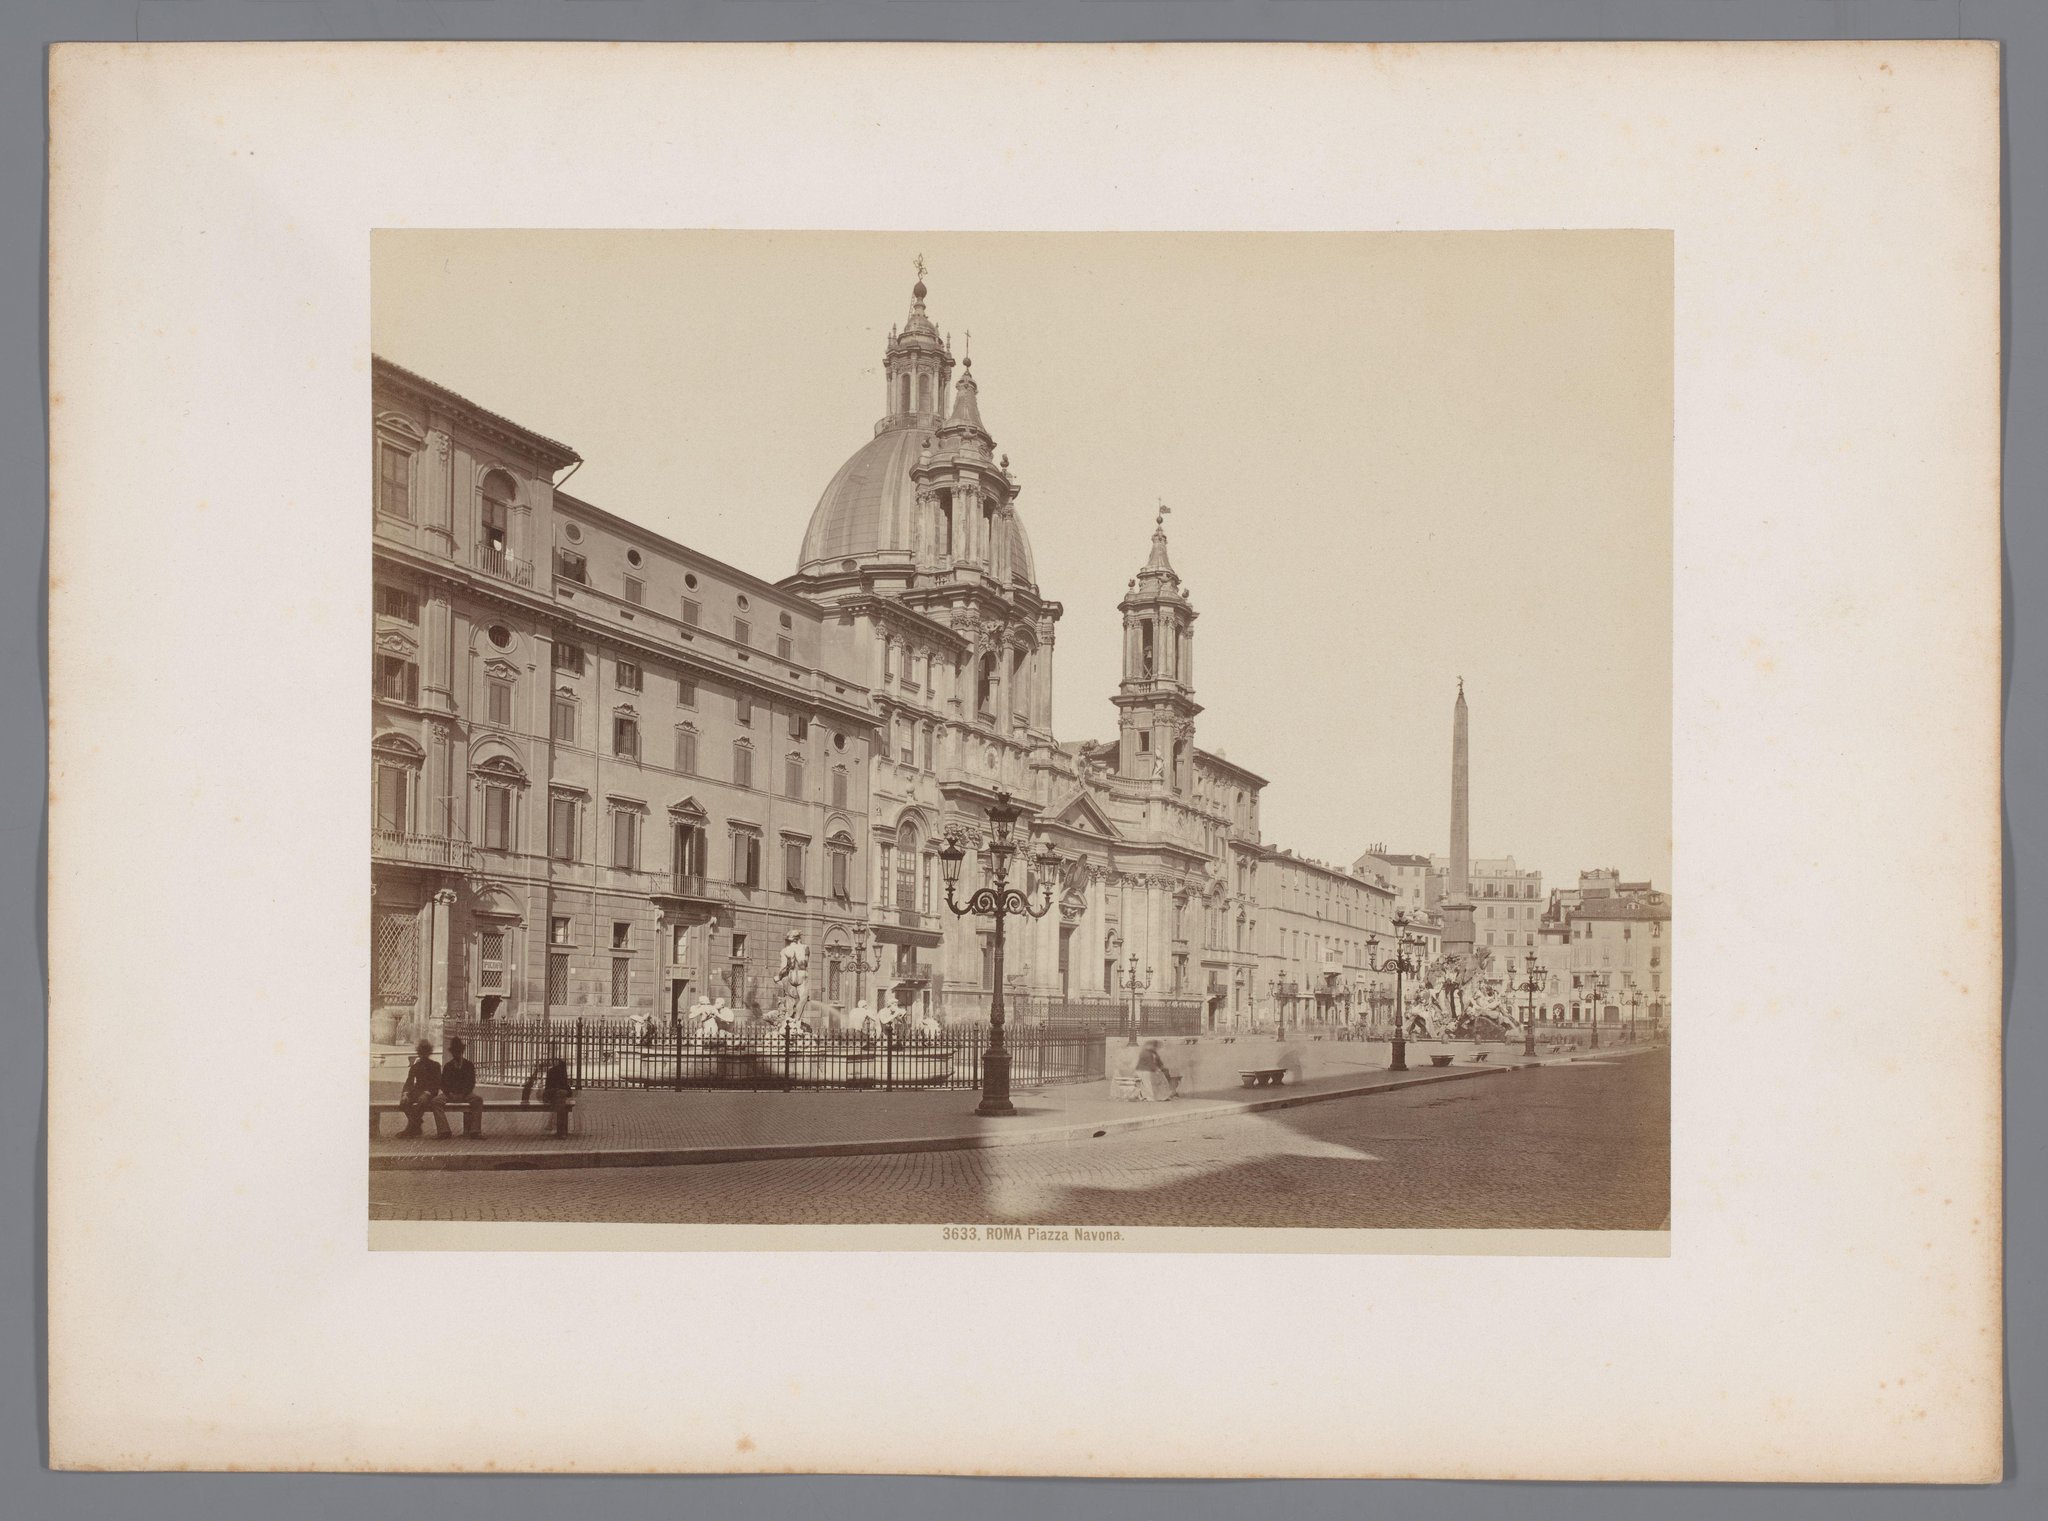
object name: photograph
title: Piazza Navona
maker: giacomo brogi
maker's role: fotograaf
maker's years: 1822-1881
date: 1864-1881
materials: cardboard, paper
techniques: albumen print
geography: rome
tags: square, place, circus, etc.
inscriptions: number: ‘3633.’, number: ‘12-’, number: ‘8’